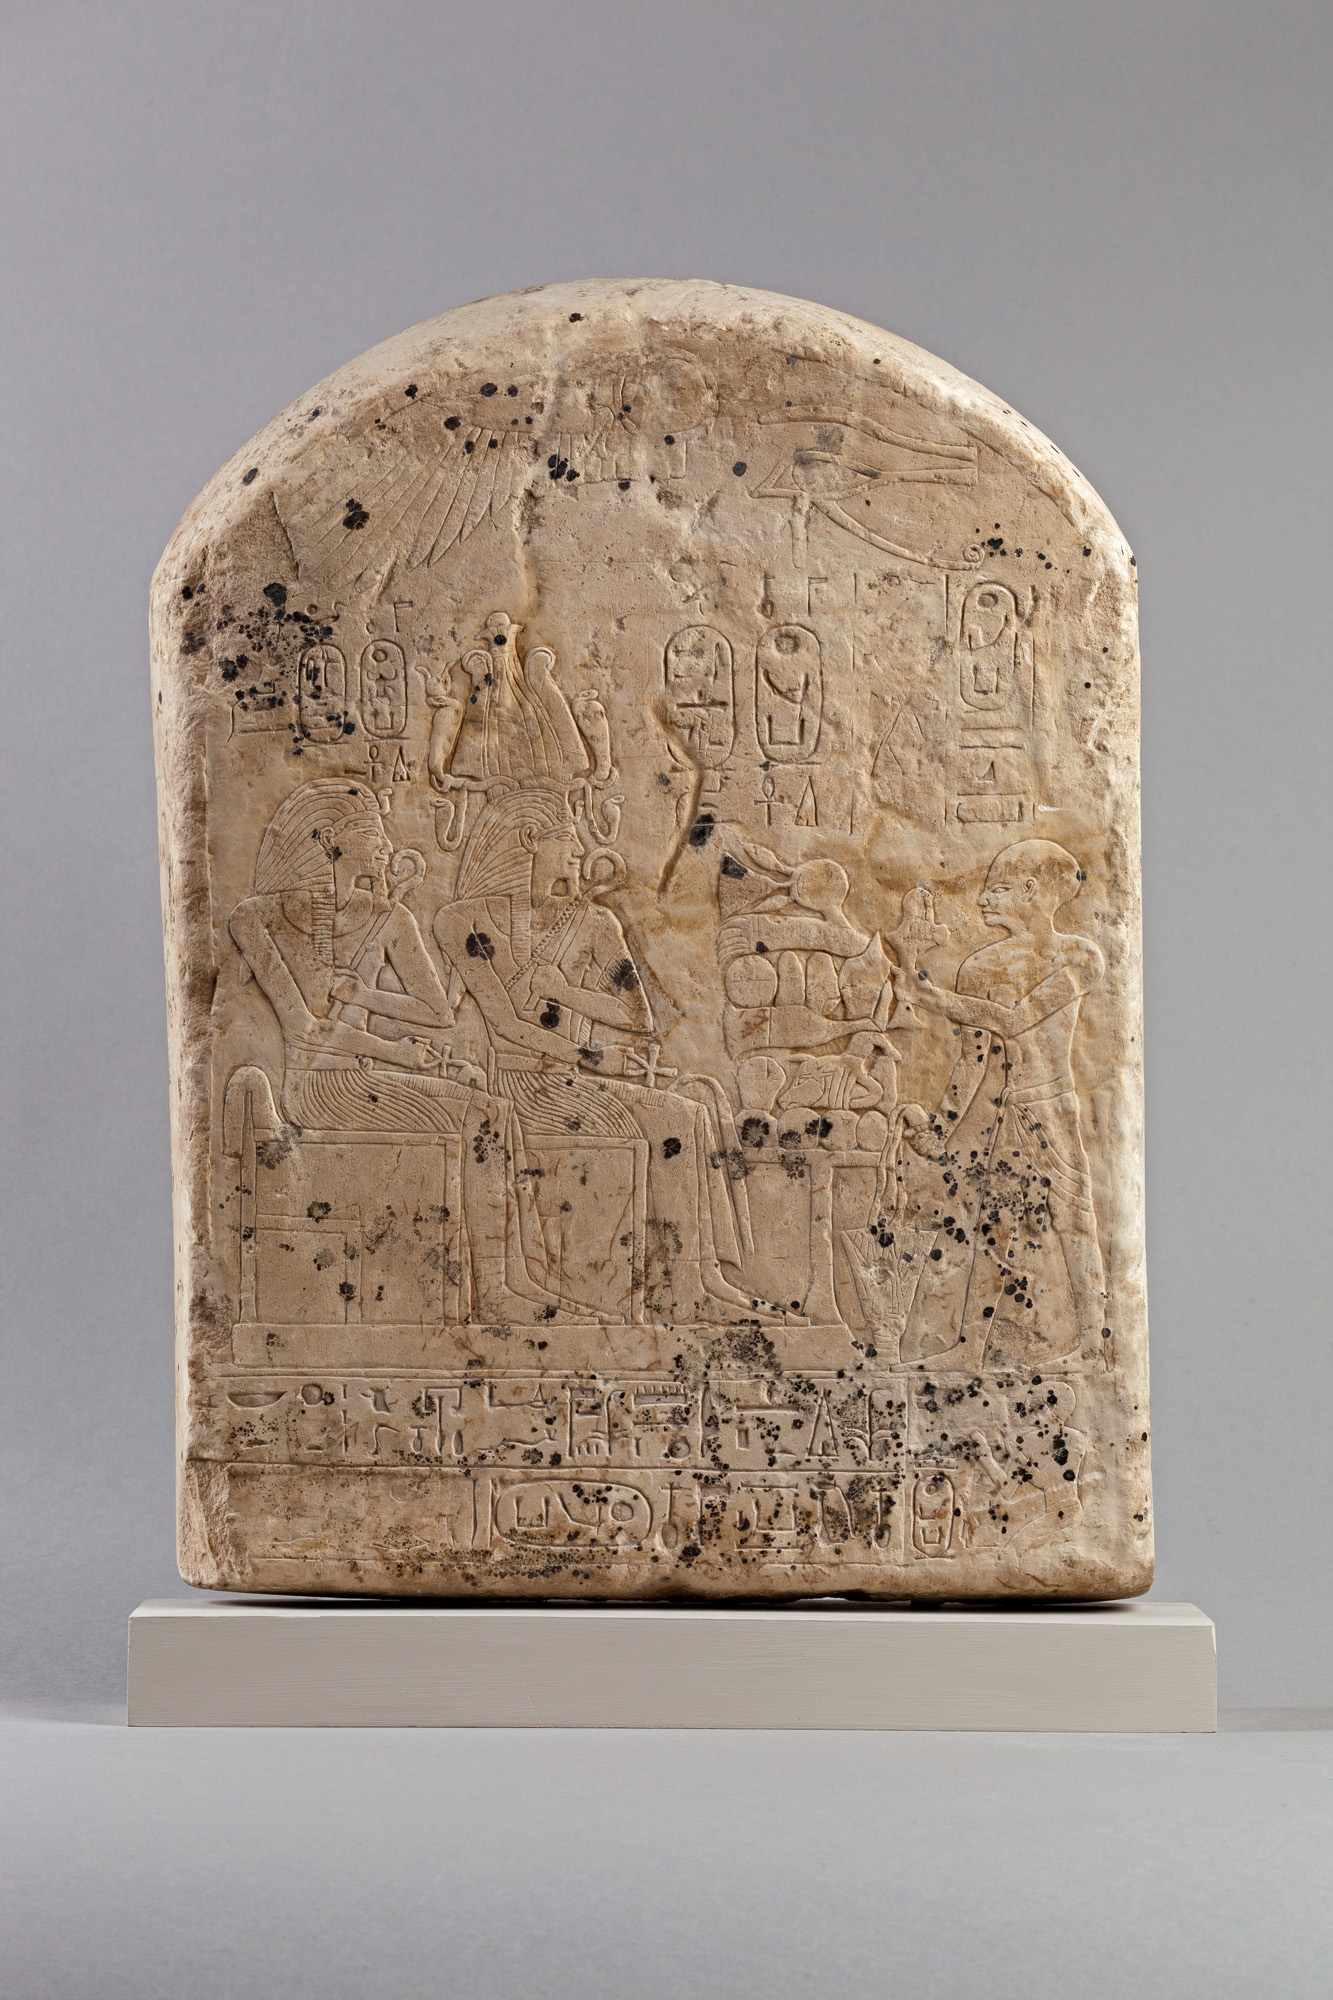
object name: stela, qenamun, amenhotep i, senwosret i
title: Stela of Qenamun worshipping Amenhotep I and Senwosret I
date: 1479-1390 BCE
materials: limestone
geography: egypt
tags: food,men,hieroglyphs